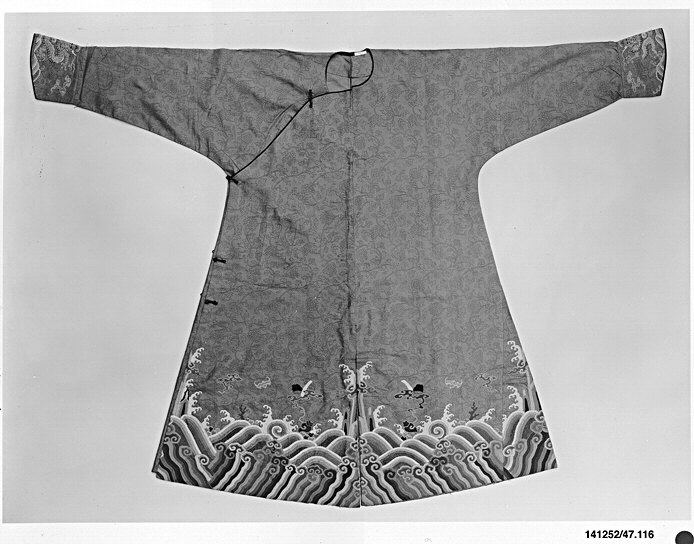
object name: robe, child's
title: Child's Robe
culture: chinese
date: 1701-1800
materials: silk